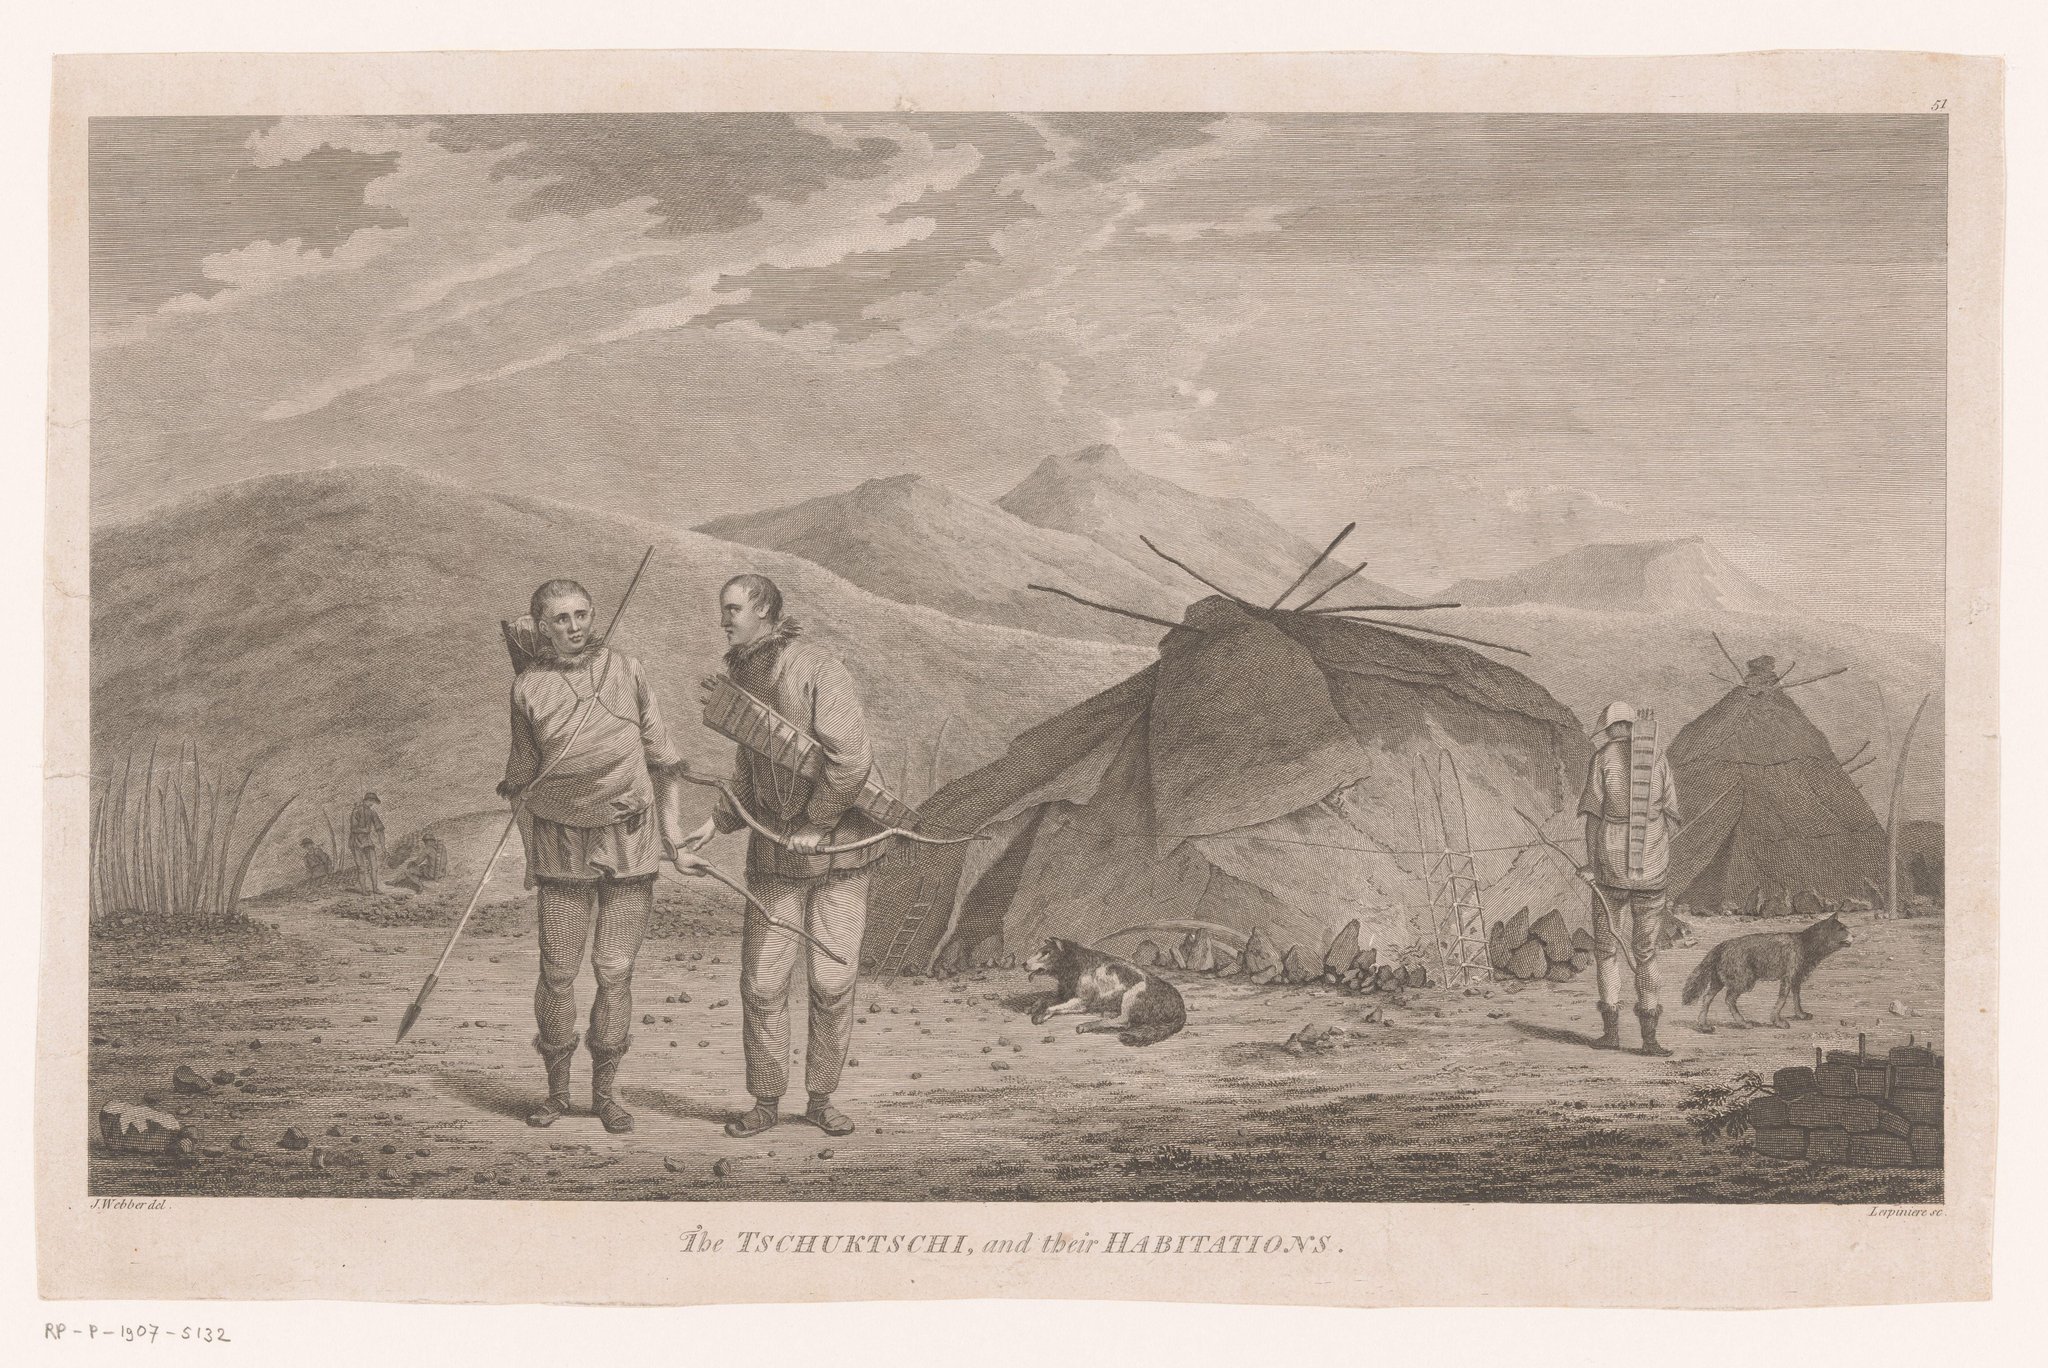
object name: print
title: The Tschuktschi, and their Habitations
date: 1760-1785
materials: paper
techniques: engraving, etching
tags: asiatic races and peoples, tent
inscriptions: collector's mark: Lugt 2228